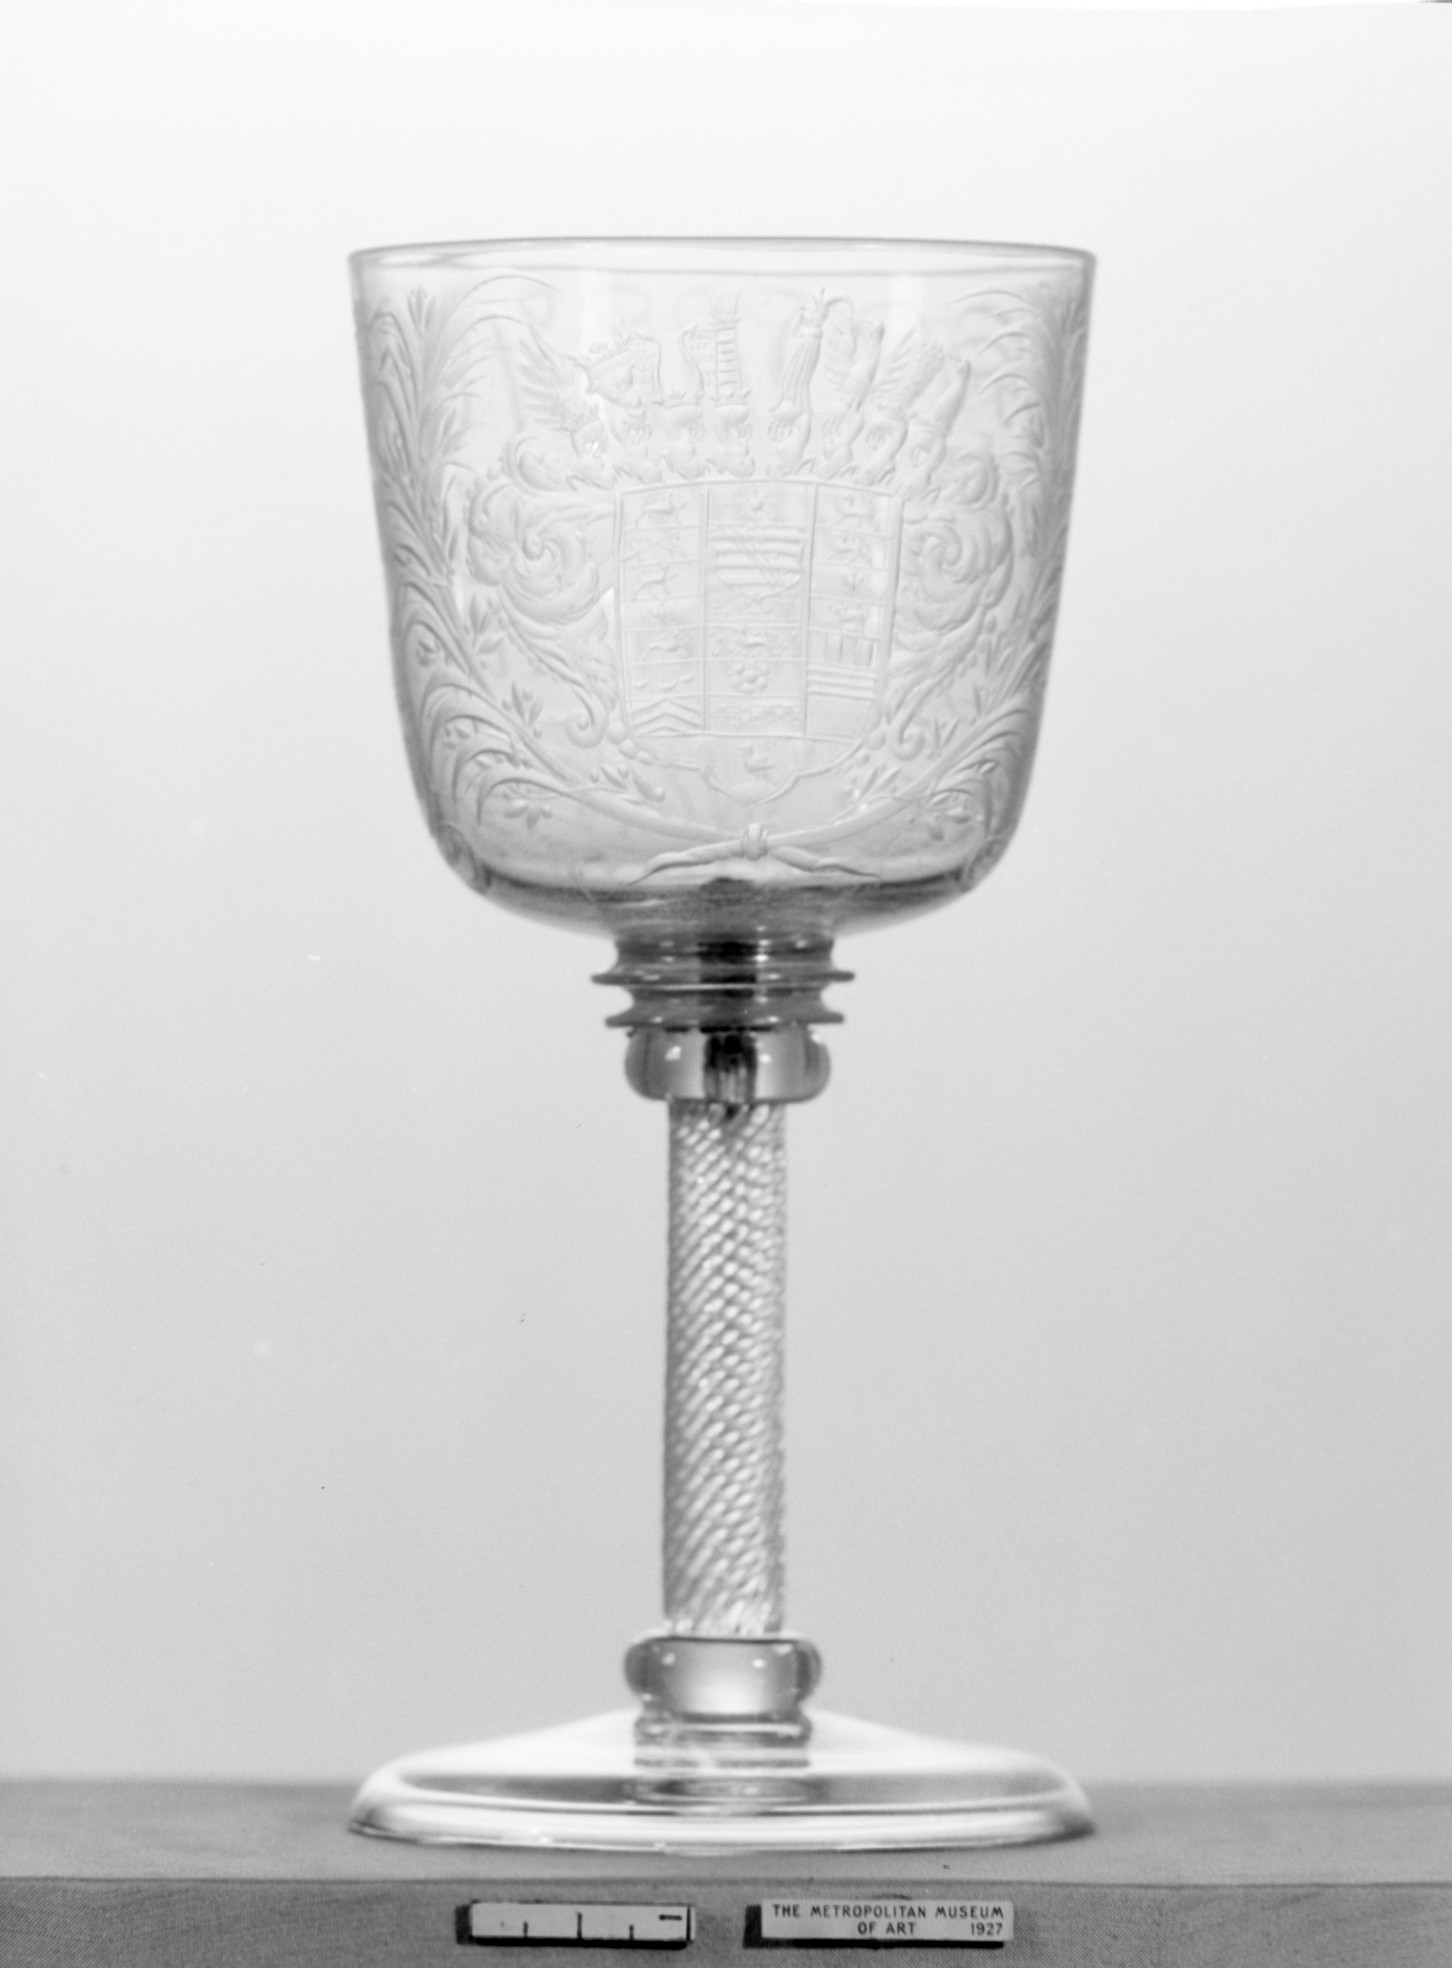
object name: standing cup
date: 1700-1750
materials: glass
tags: coat of arms